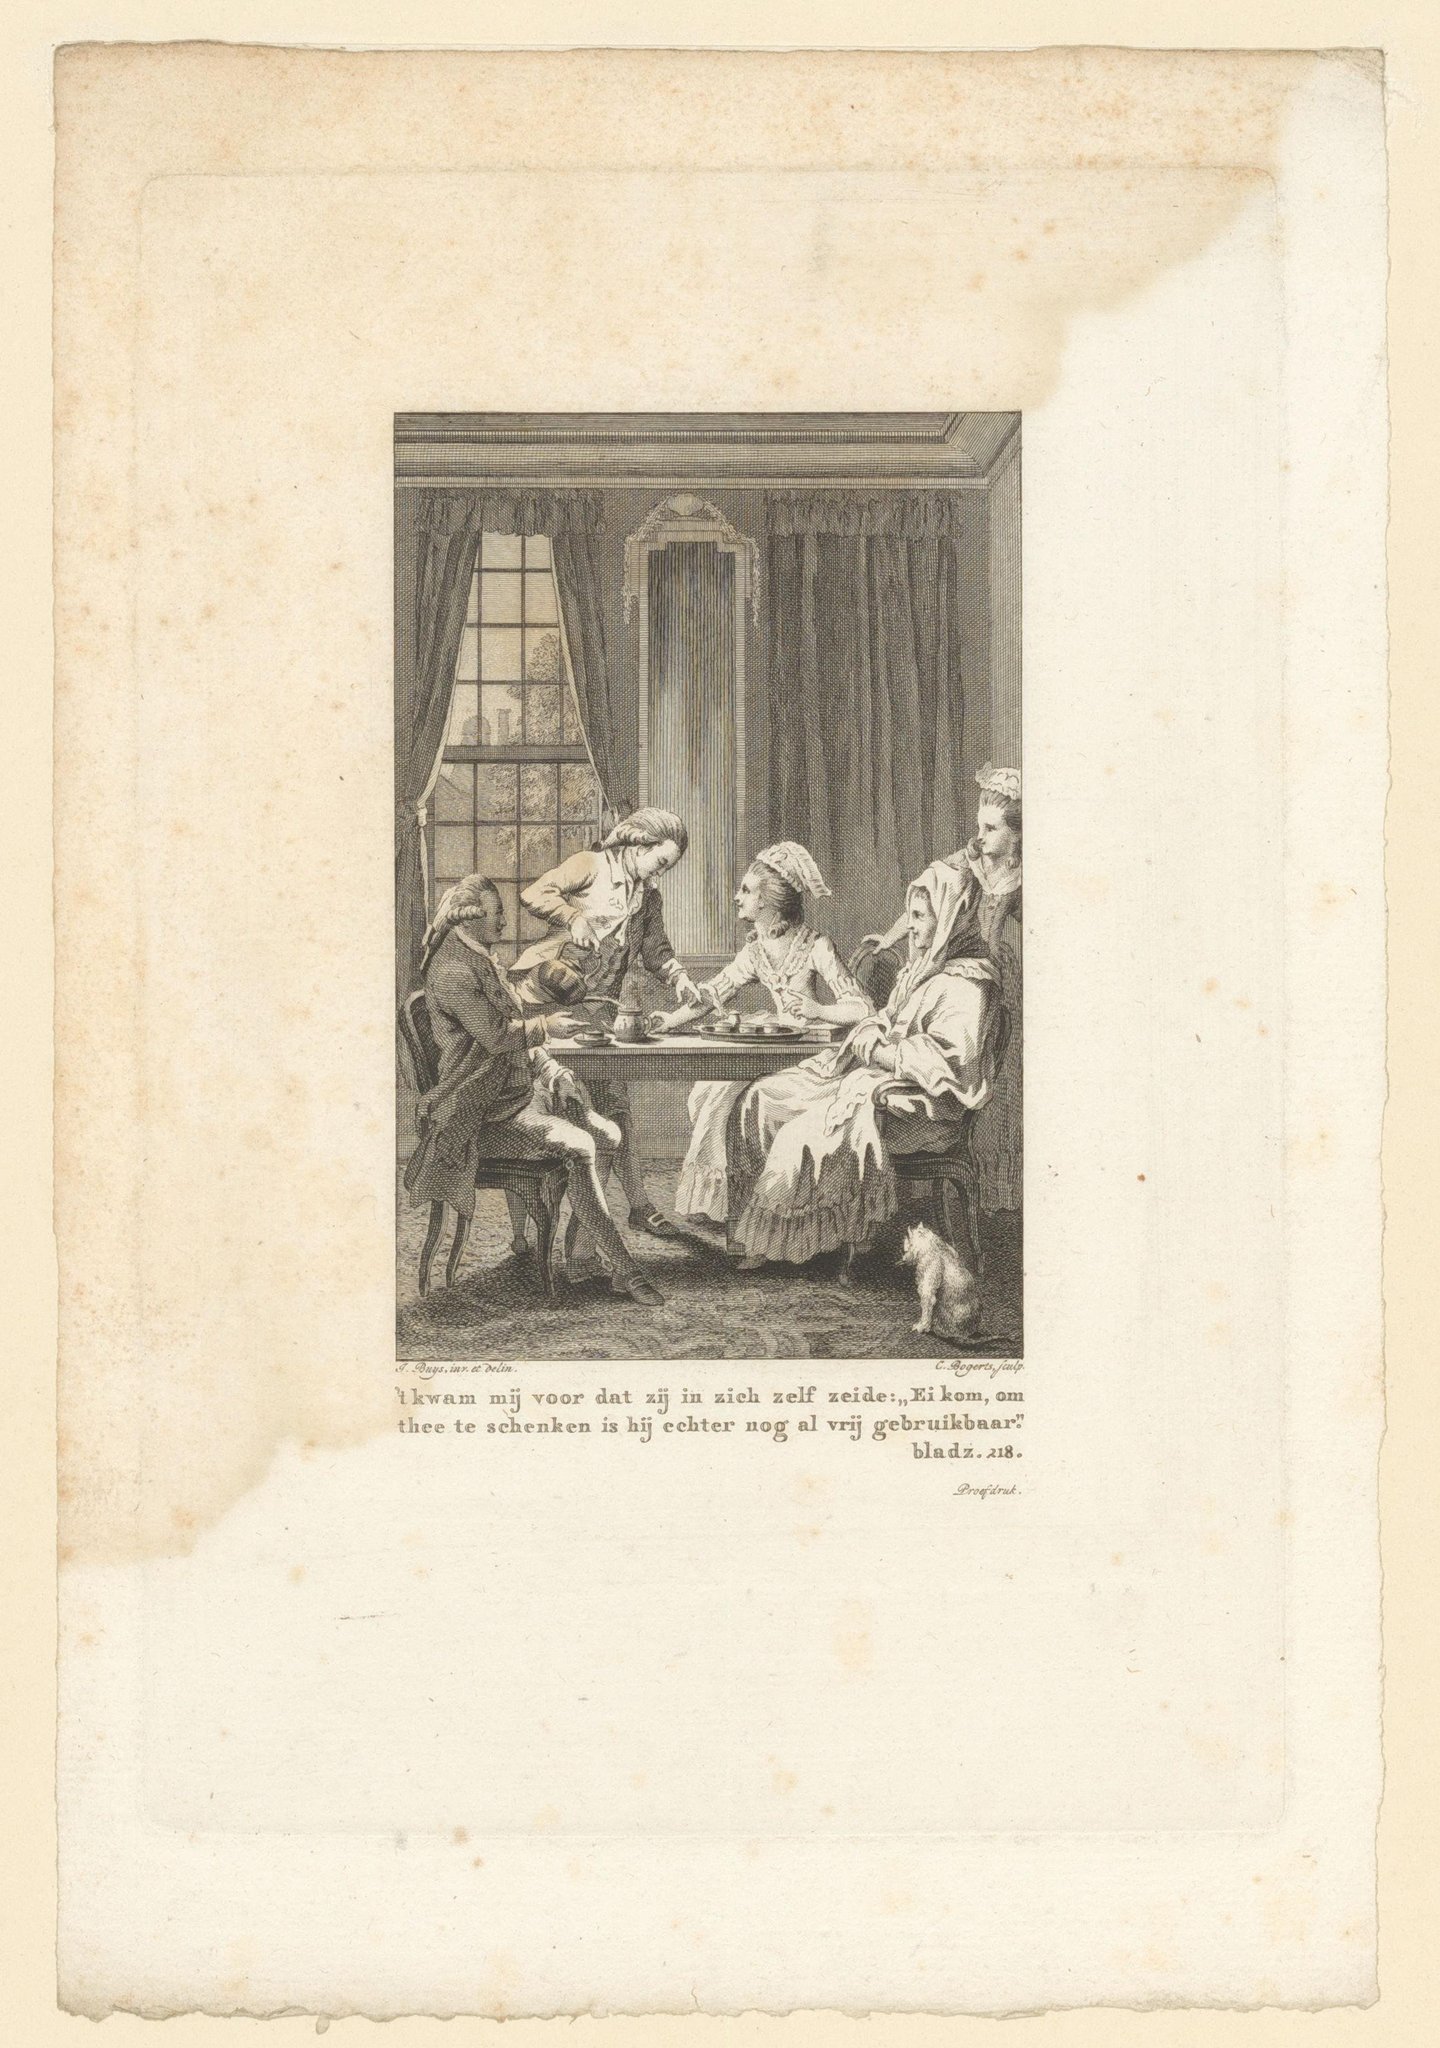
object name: print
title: Illustratie voor 'Historie van mejuffrouw Sara Burgerhart', 1782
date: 1782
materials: paper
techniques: engraving, etching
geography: netherlands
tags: communal rooms, family life at home, afternoon tea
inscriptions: collector's mark, collector's mark: Lugt 1641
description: Gebruikt als illustratie in: E. Bekker en A. Deken, Historie van mejuffrouw Sara Burgerhart, Den Haag: Isaac van Cleef, 1782.